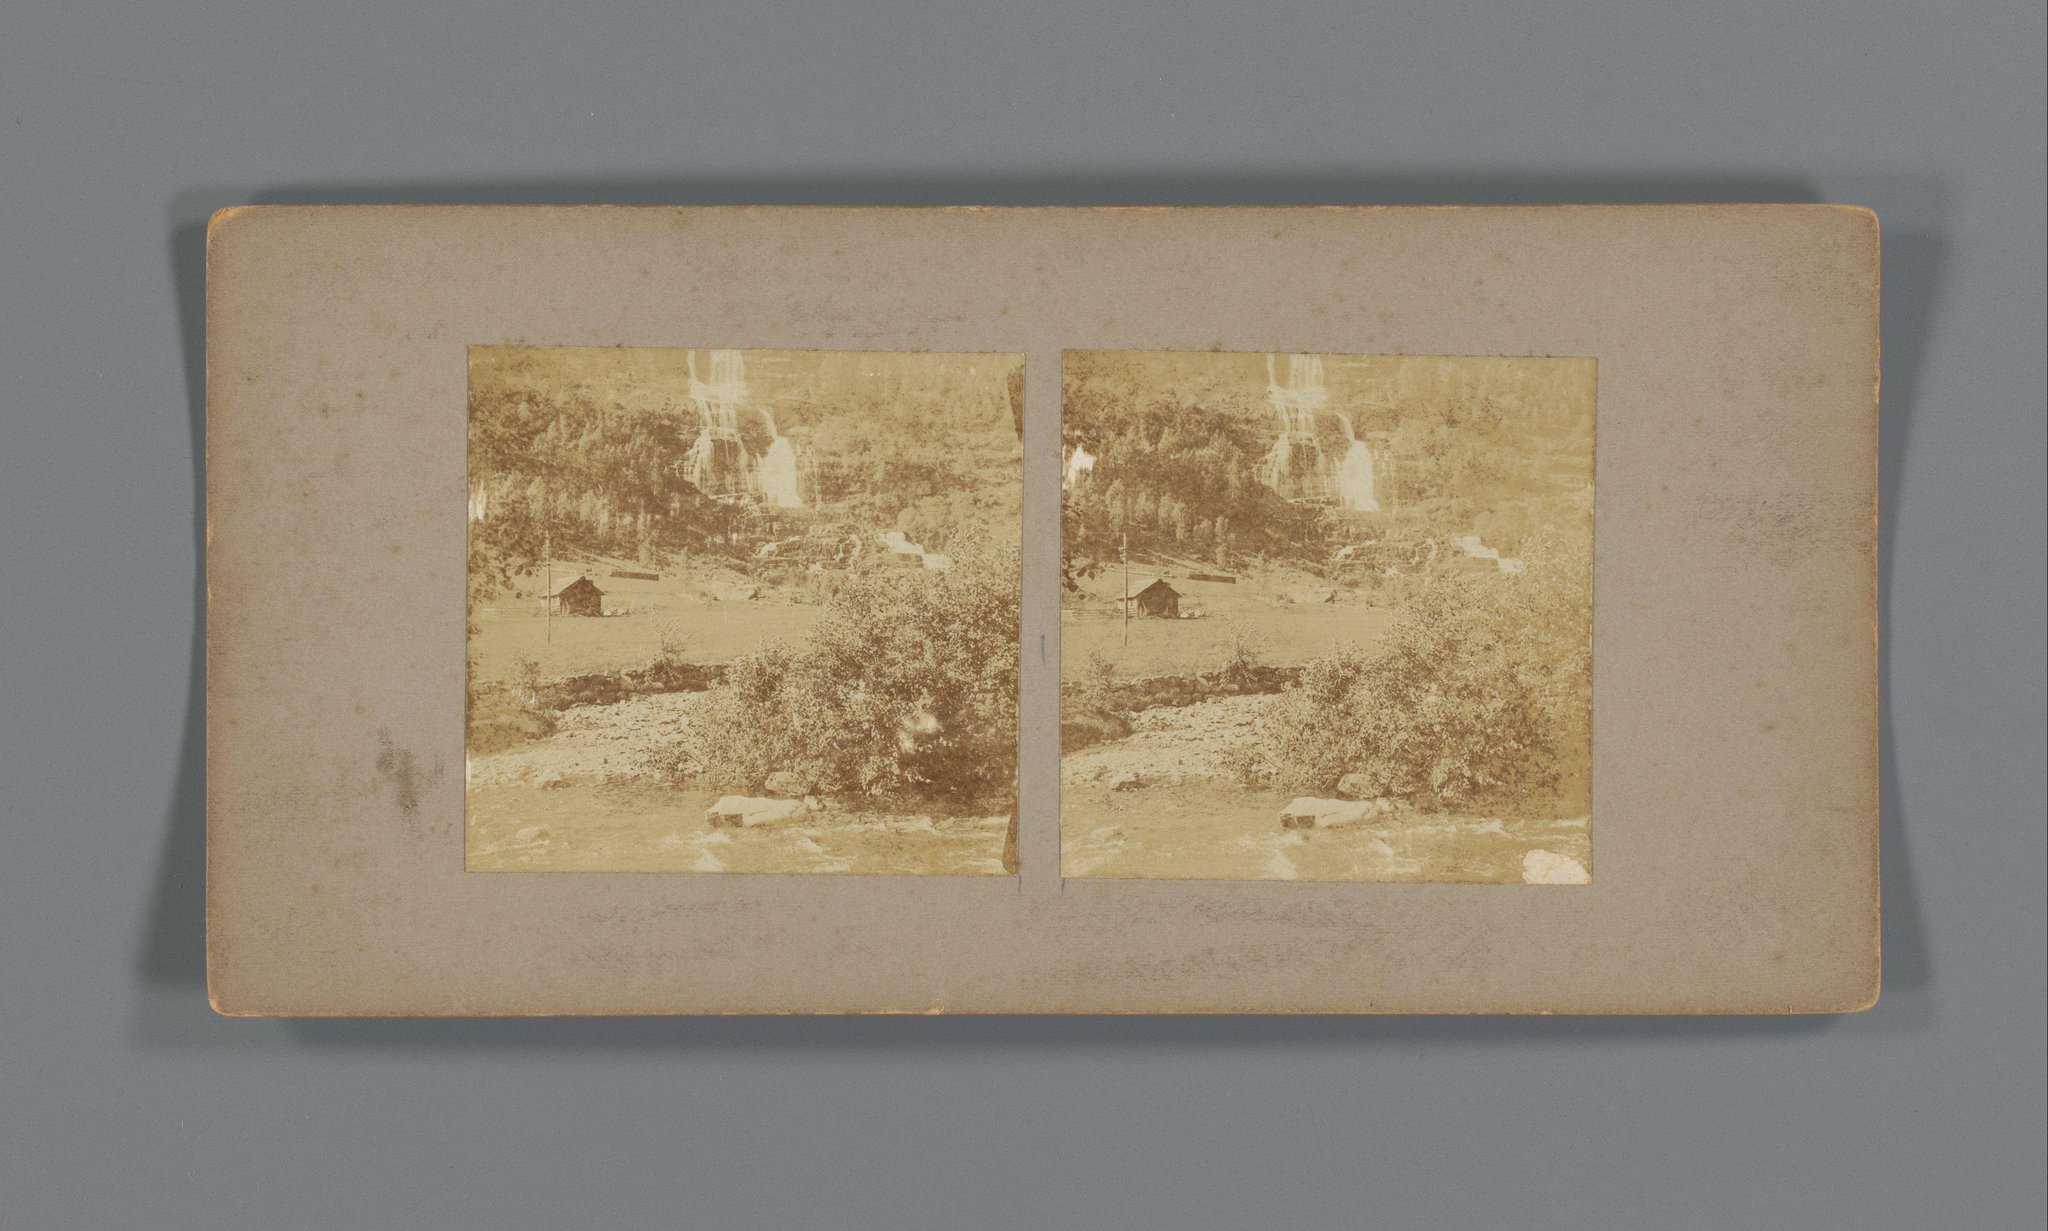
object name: stereograph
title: Tvende waterval bij Vossevanger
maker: Anonymous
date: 1882-1890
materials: cardboard, photographic support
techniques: gelatin silver print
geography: voss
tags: waterfall